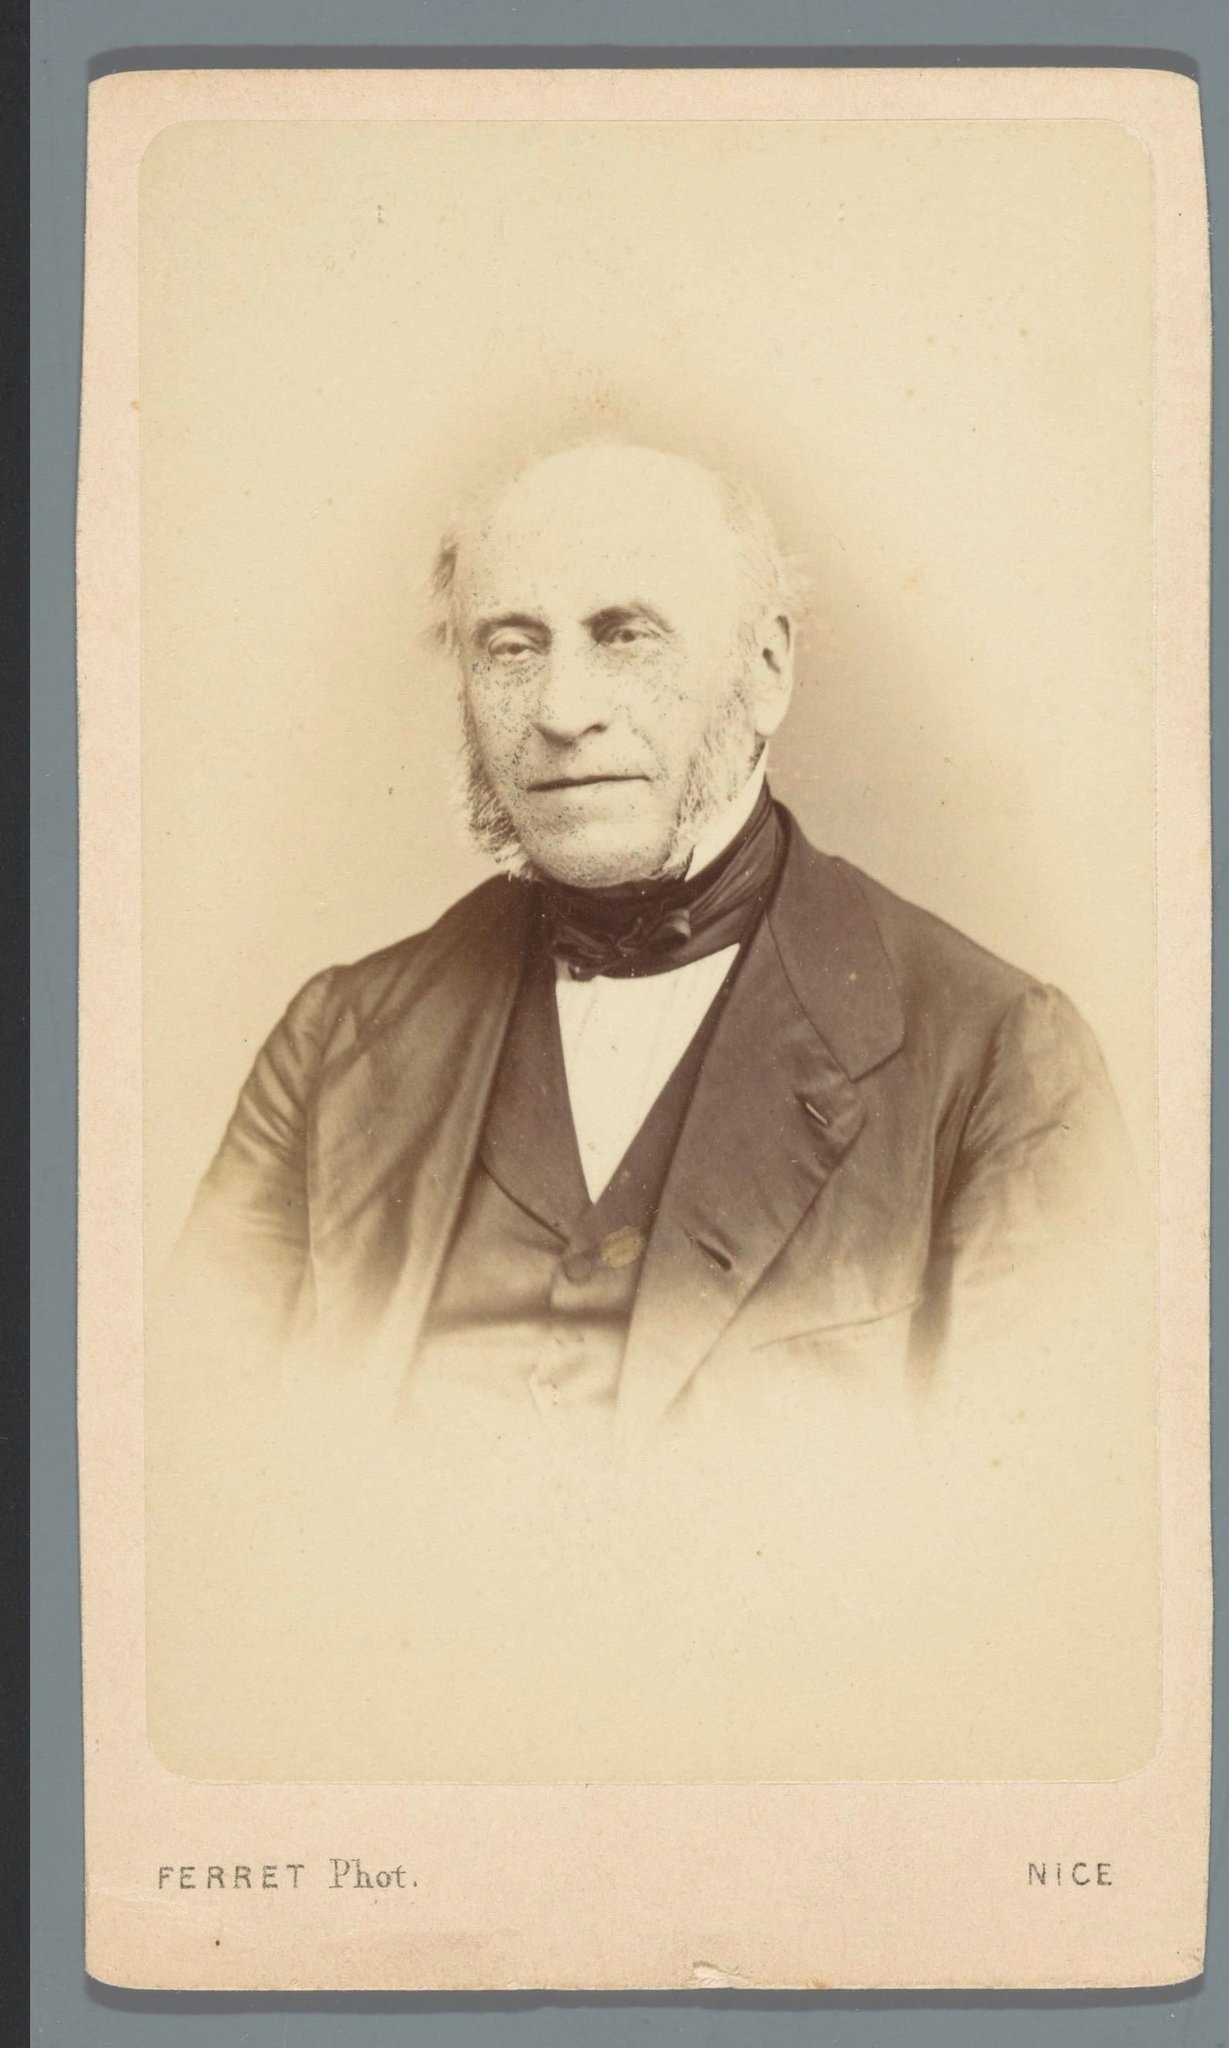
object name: photograph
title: Portret van een onbekende oude man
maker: pierre ferret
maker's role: fotograaf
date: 1855-1885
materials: cardboard, paper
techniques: albumen print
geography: nice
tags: old man, anonymous historical person portrayed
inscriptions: inscription: ‘Ferret Phot. Nice’, inscription: ‘Photographe/ de L.L.M. l. Empereur Napoleon III/ et de/ l'Impératrice de Russie/ Rue Gioffredo/ Nice/ Ferret’